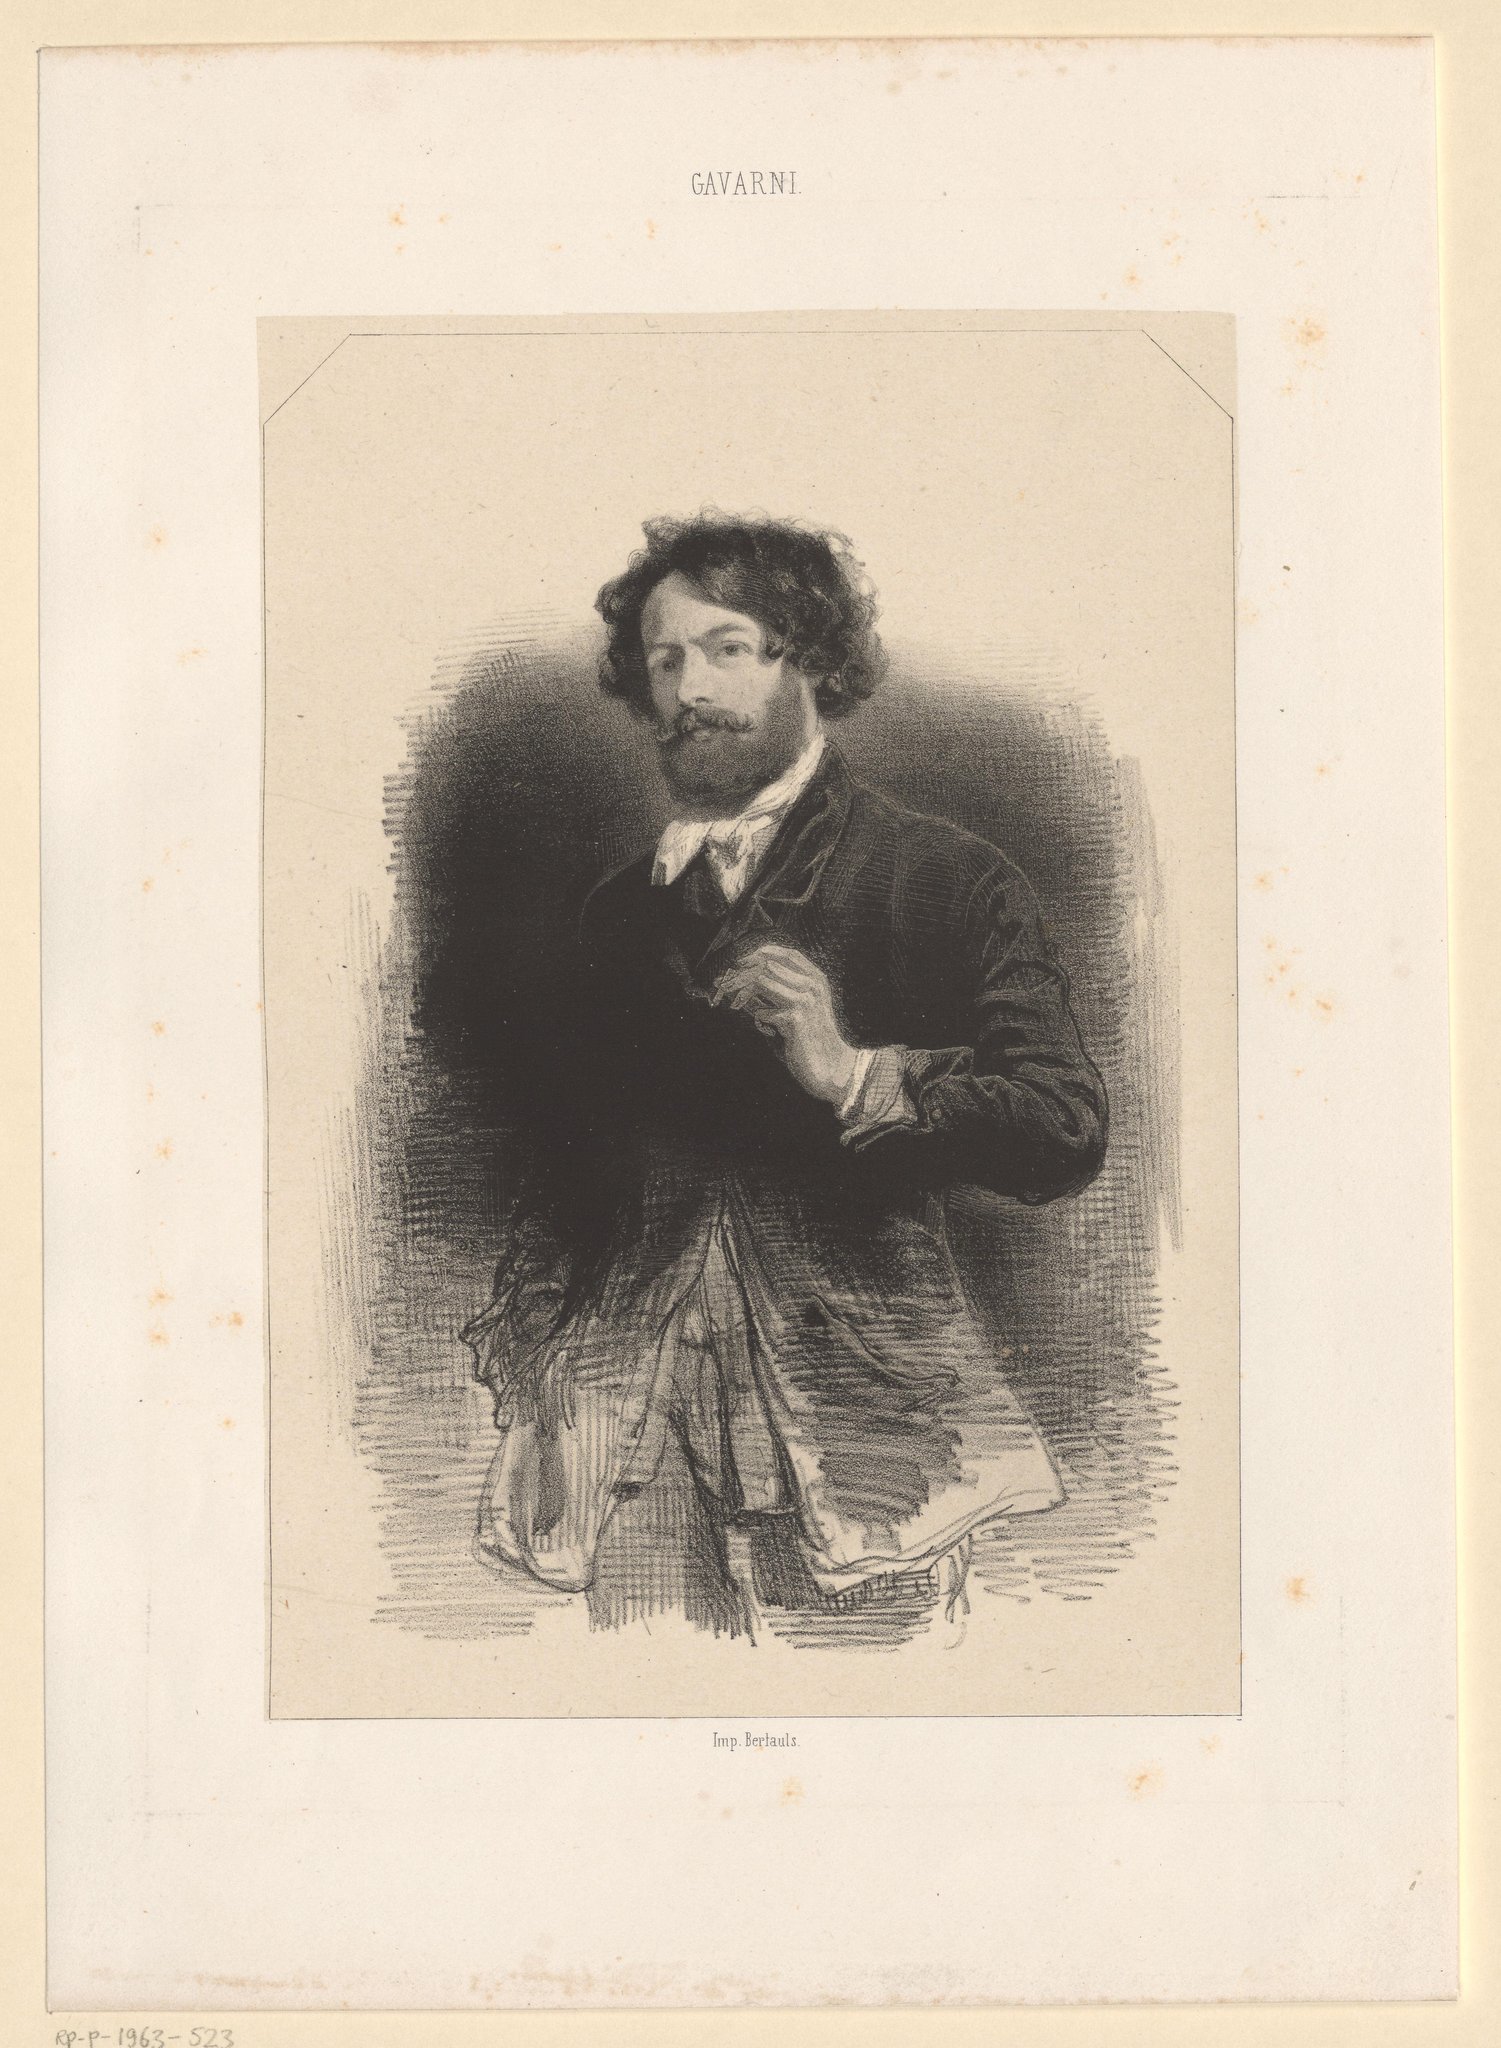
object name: print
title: Zelfportret met sigaret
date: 1842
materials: paper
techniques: tone lithography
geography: paris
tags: paul gavarni, historical persons, portrait, self-portrait of graphic artist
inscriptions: collector's mark: Lugt 2228